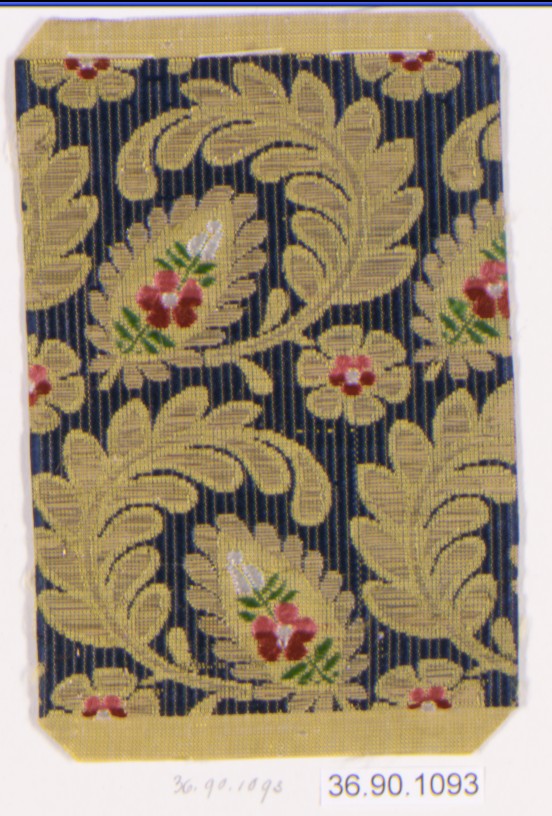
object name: sample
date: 1701-1900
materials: metal thread, silk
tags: flowers,leaves